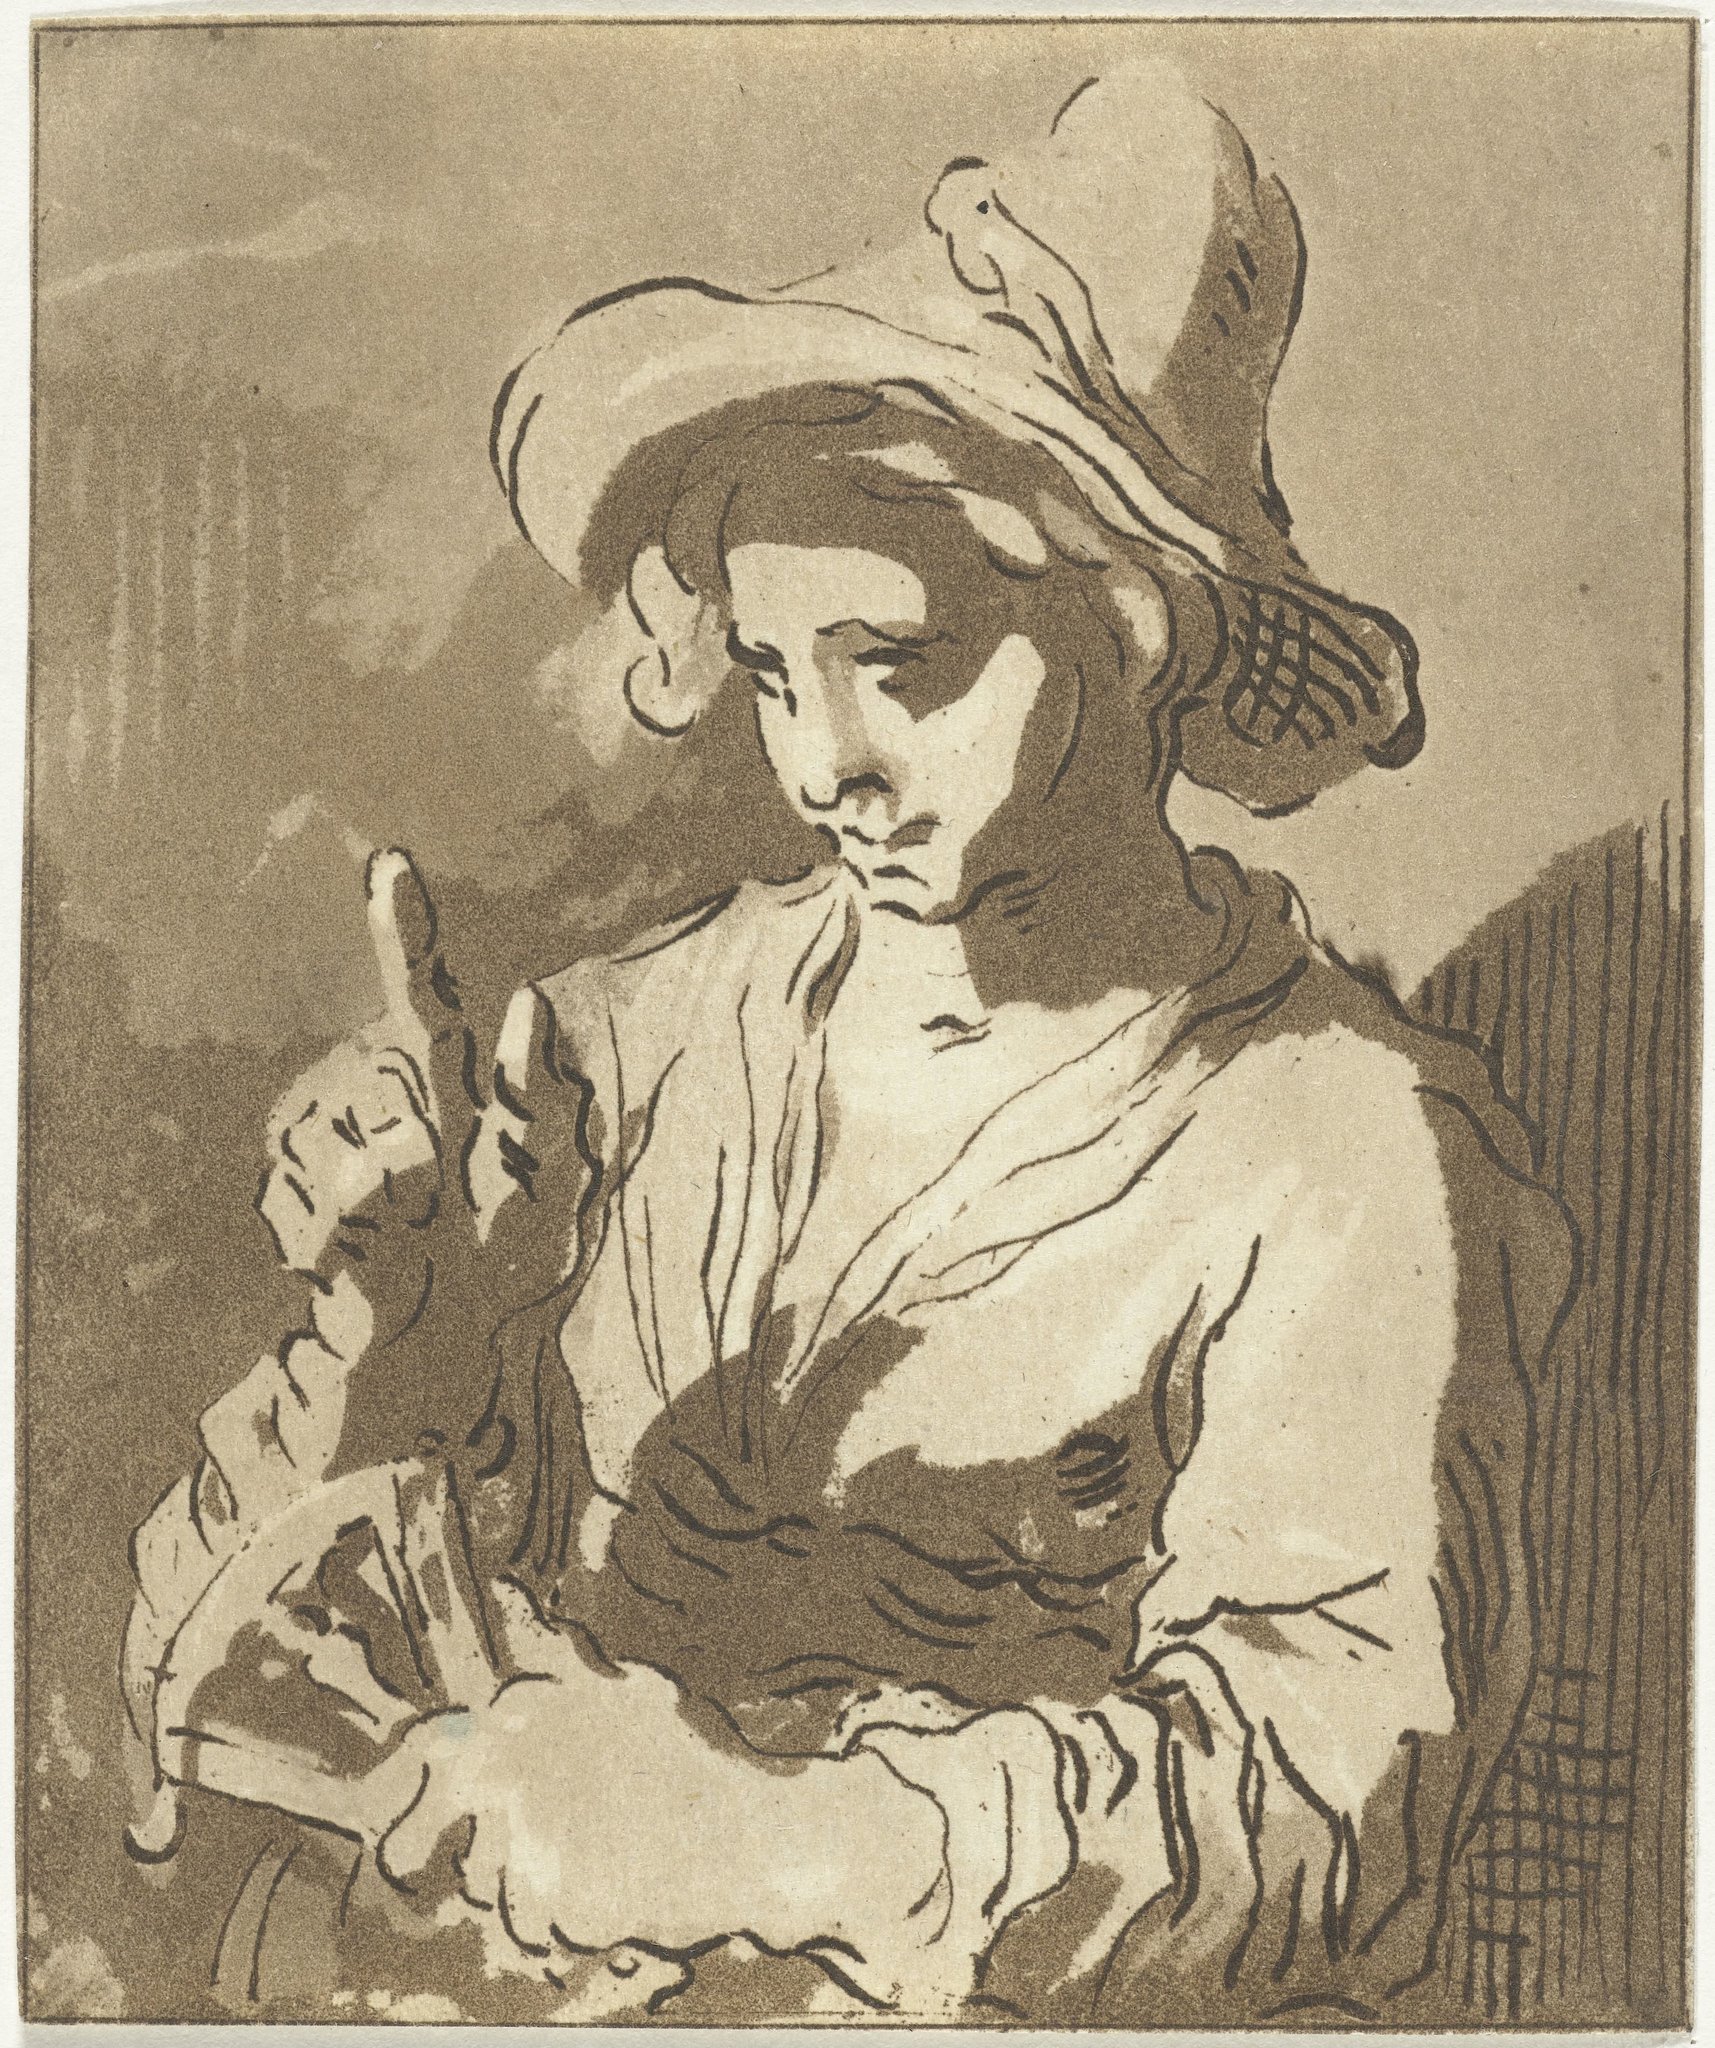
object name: print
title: Jonge vrouw met waaier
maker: anthonie van den bos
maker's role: draughtsman, print maker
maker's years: 1763-1838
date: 1778-1838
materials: paper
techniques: aquatint, etching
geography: netherlands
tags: fan, index finger upwards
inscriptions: collector's mark: Lugt 2228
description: Een jonge vrouw met een grote hoed en een waaier in haar hand. Met haar rechter wijsvinger maakt ze een spreekgebaar.